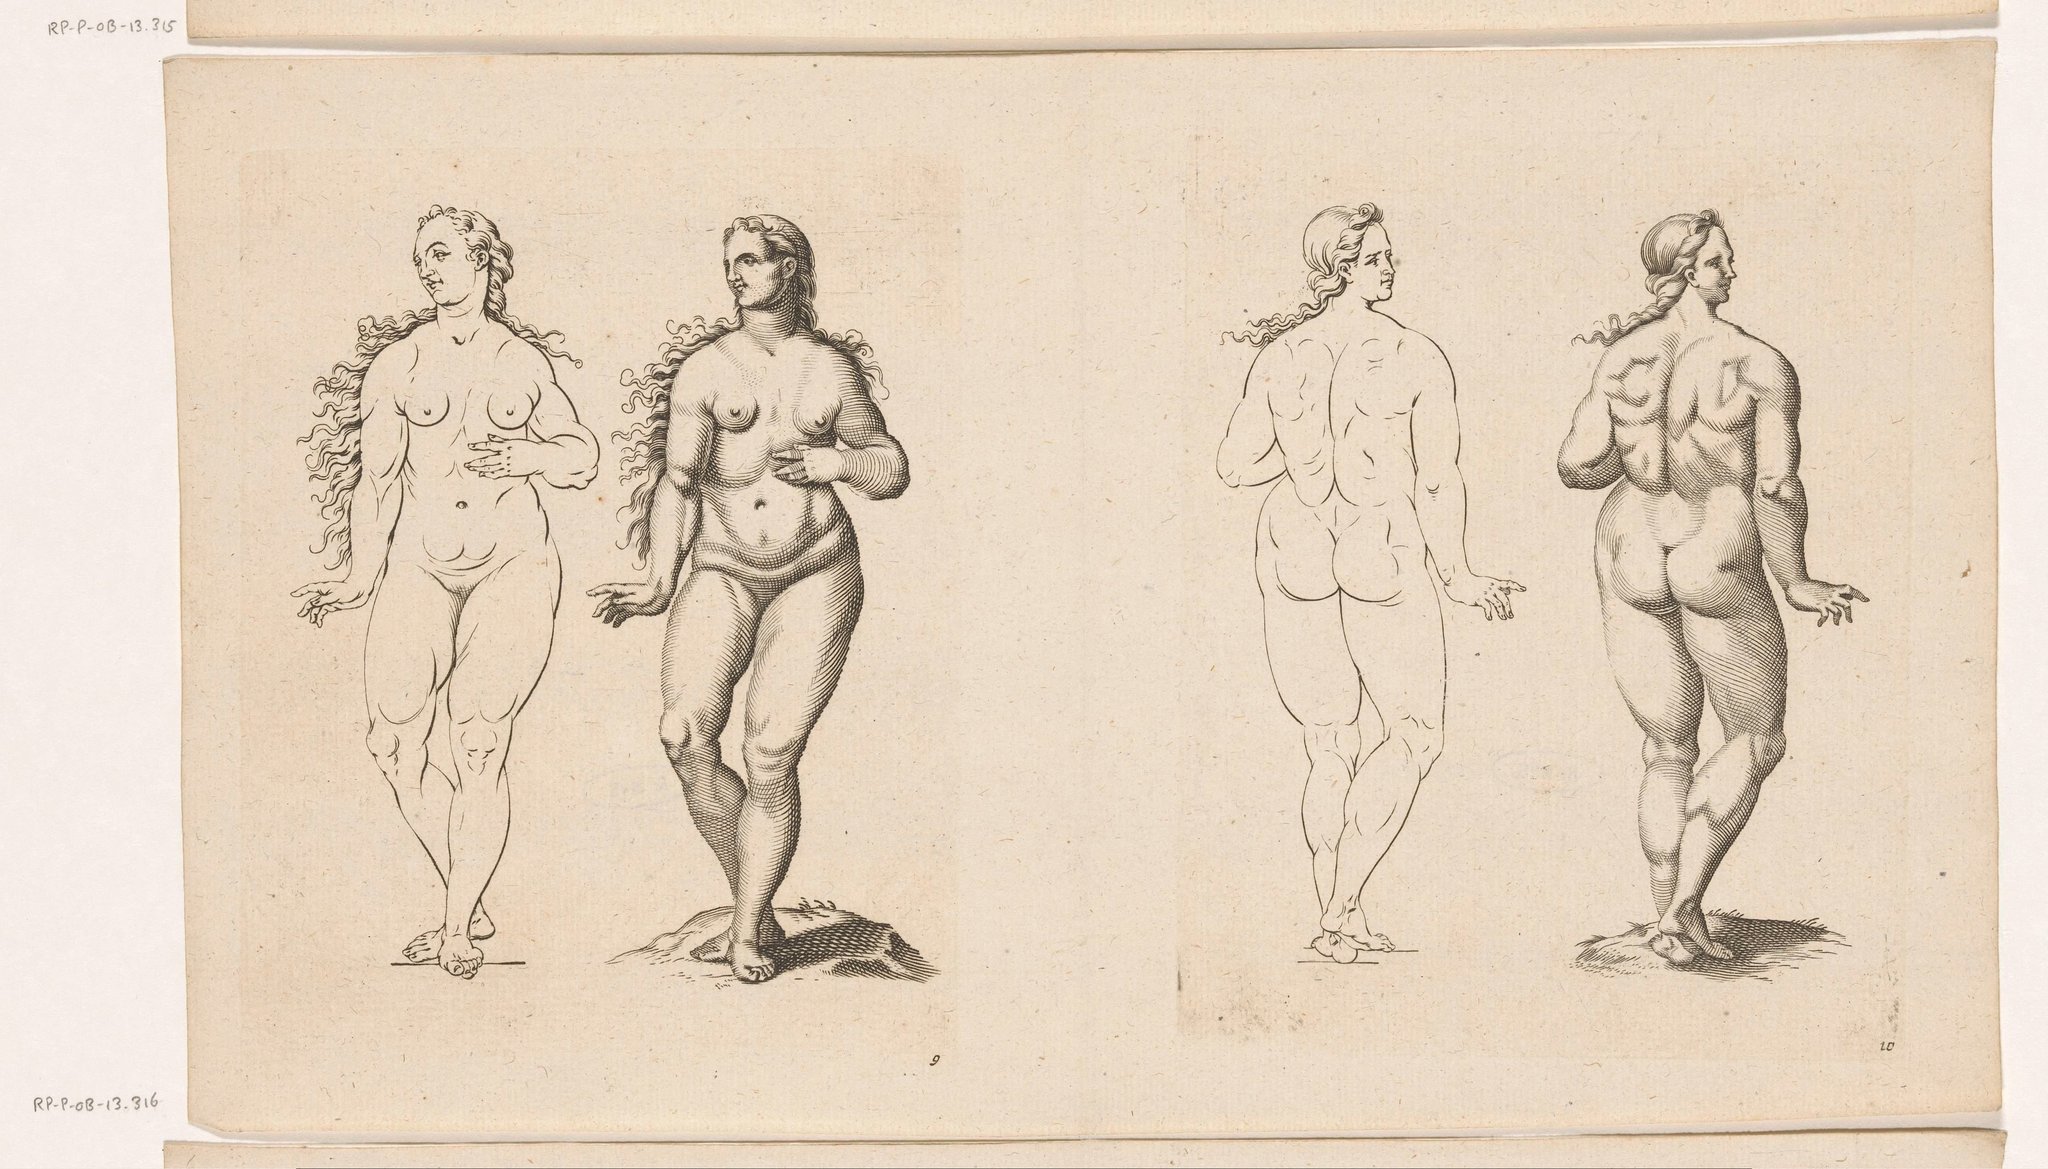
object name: print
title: Vrouwelijk naakt, vooraanzicht en rugaanzicht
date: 1645-1706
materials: paper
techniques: engraving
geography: amsterdam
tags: the (nude) human figure; 'corpo humano' (ripa) - aa - female human figure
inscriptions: collector's mark: Lugt 2228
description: Twee prenten op een blad, genummerd 9 en 10.